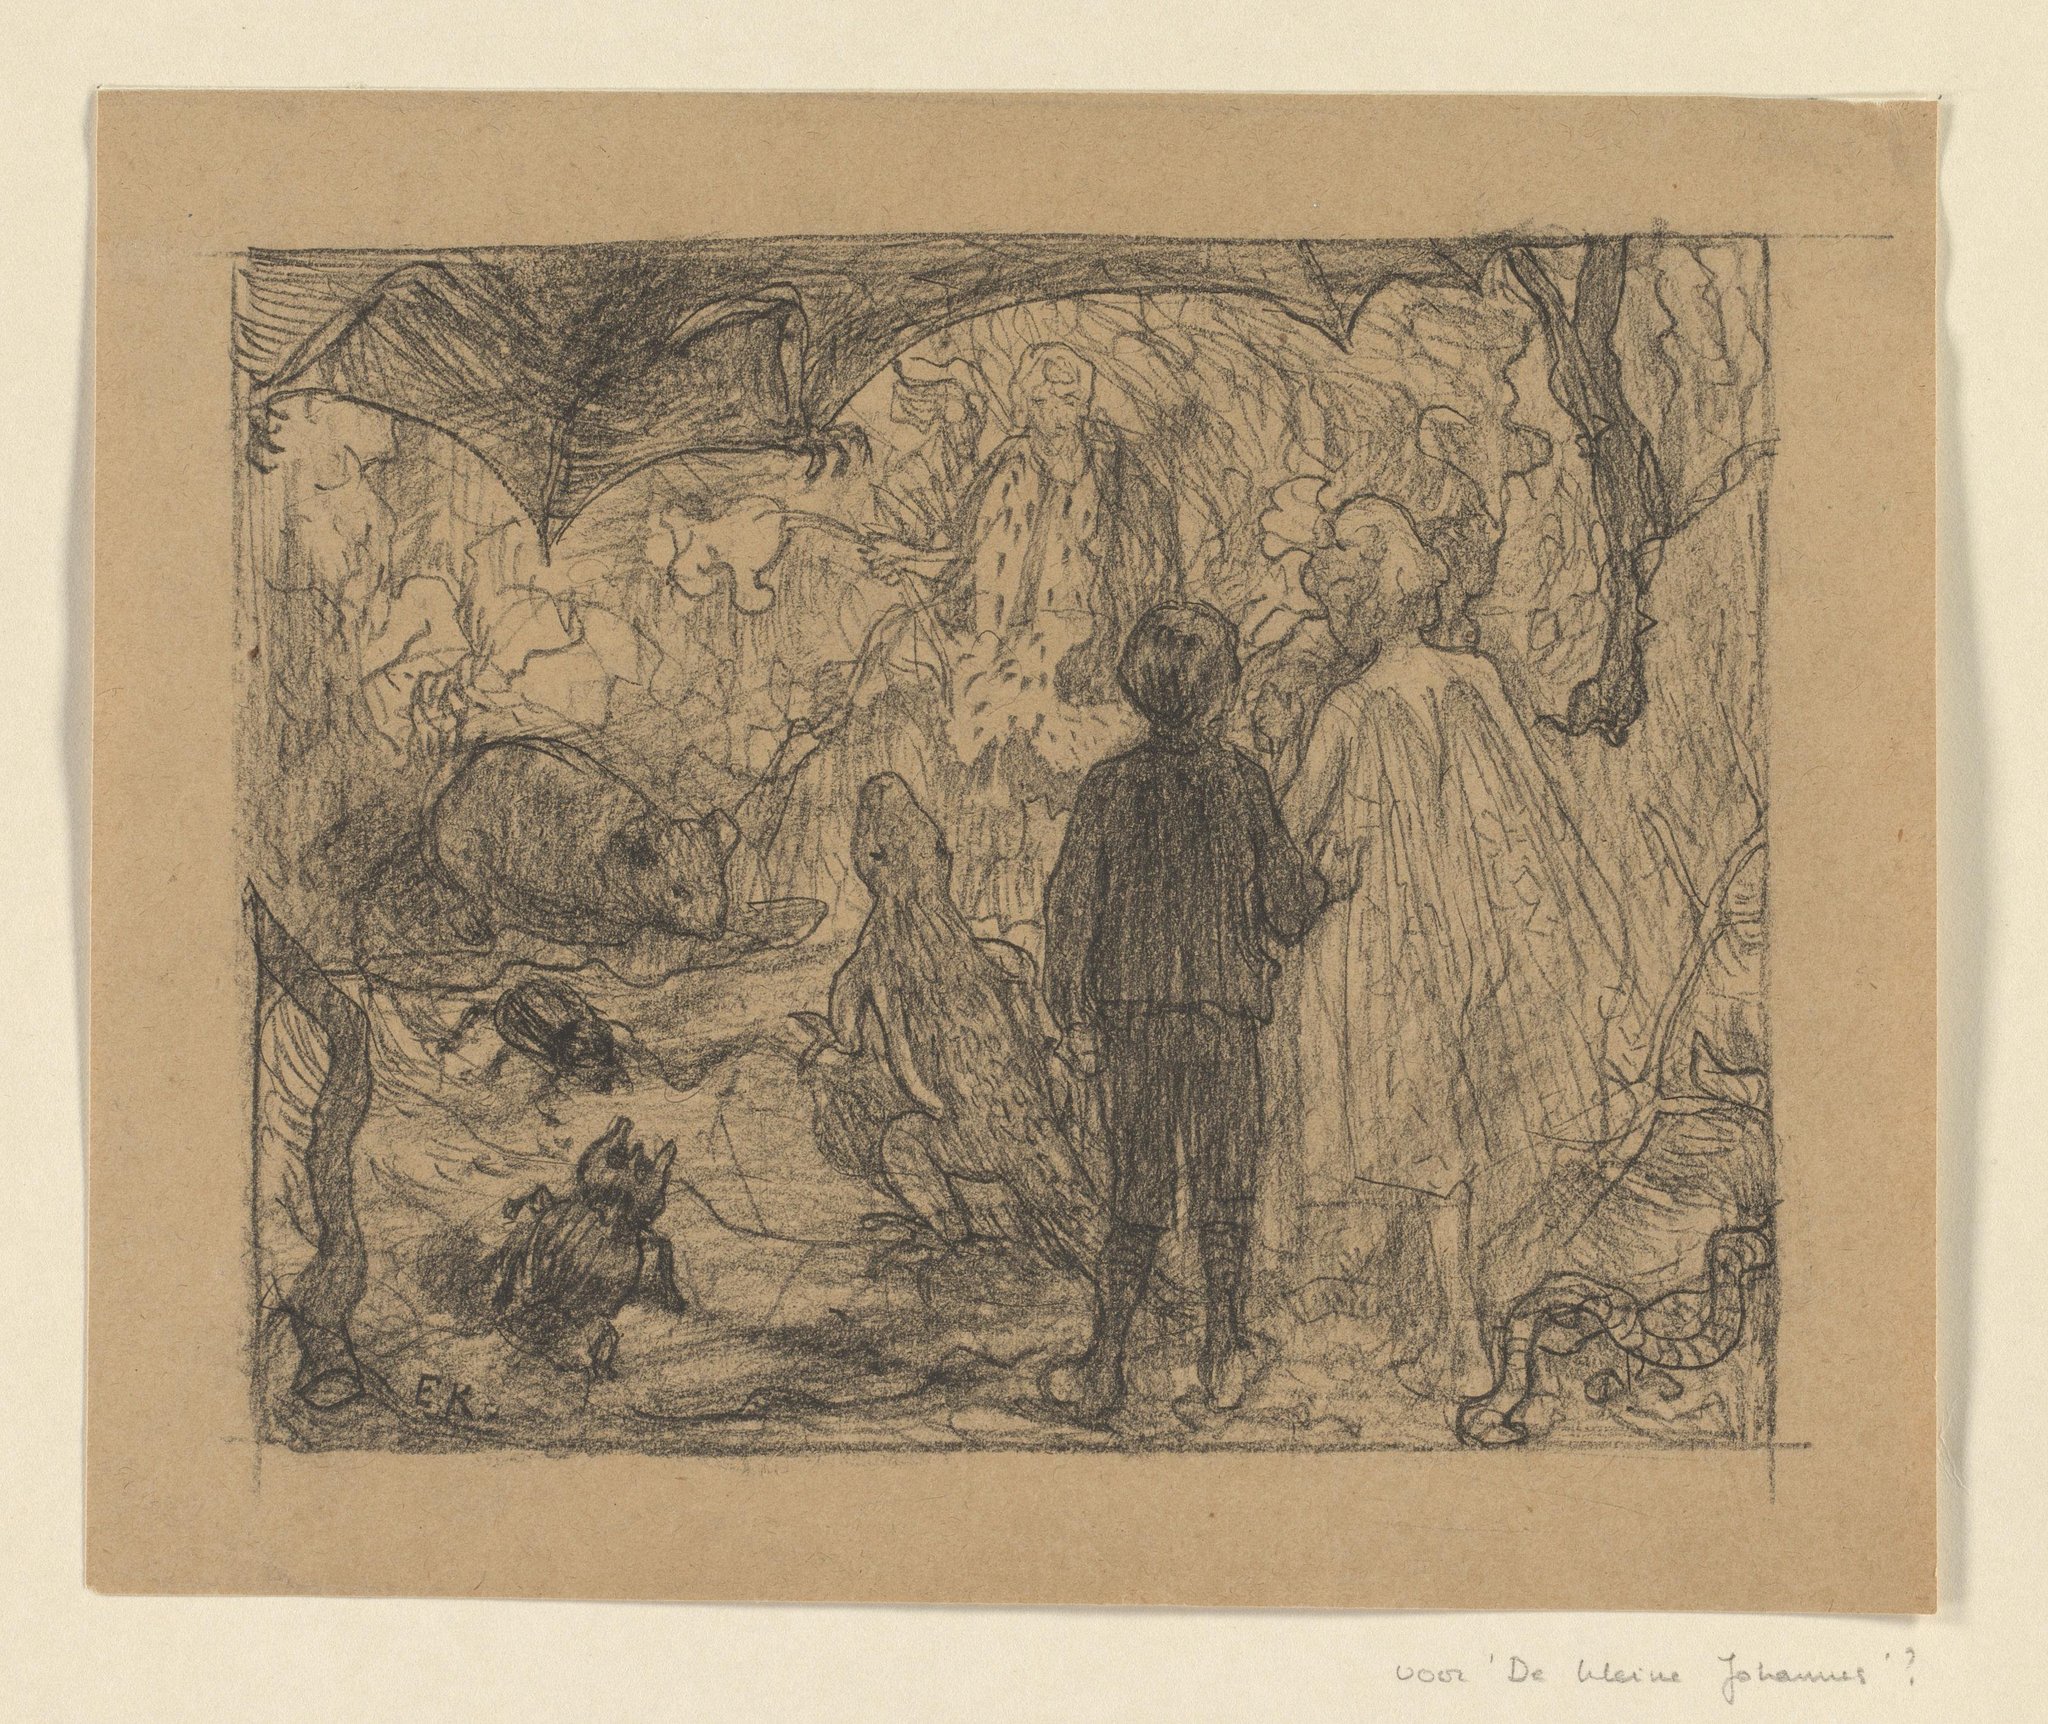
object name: boekillustratie ontwerp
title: Johannes en Windekind omringd door dieren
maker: edzard koning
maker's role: draughtsman, print maker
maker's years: 1869-1954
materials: chalk, paper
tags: animals, (van eeden, de kleine johannes) specific works of literature (with author, title), boy (child between toddler and youth), fairy, insects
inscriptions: collector's mark: Lugt 2228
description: Ontwerp voor: Eeden, Frederik van. De kleine Johannes. Den Haag: Mouton & Co., 1898. Niet gebruikt in de definitieve uitgave.